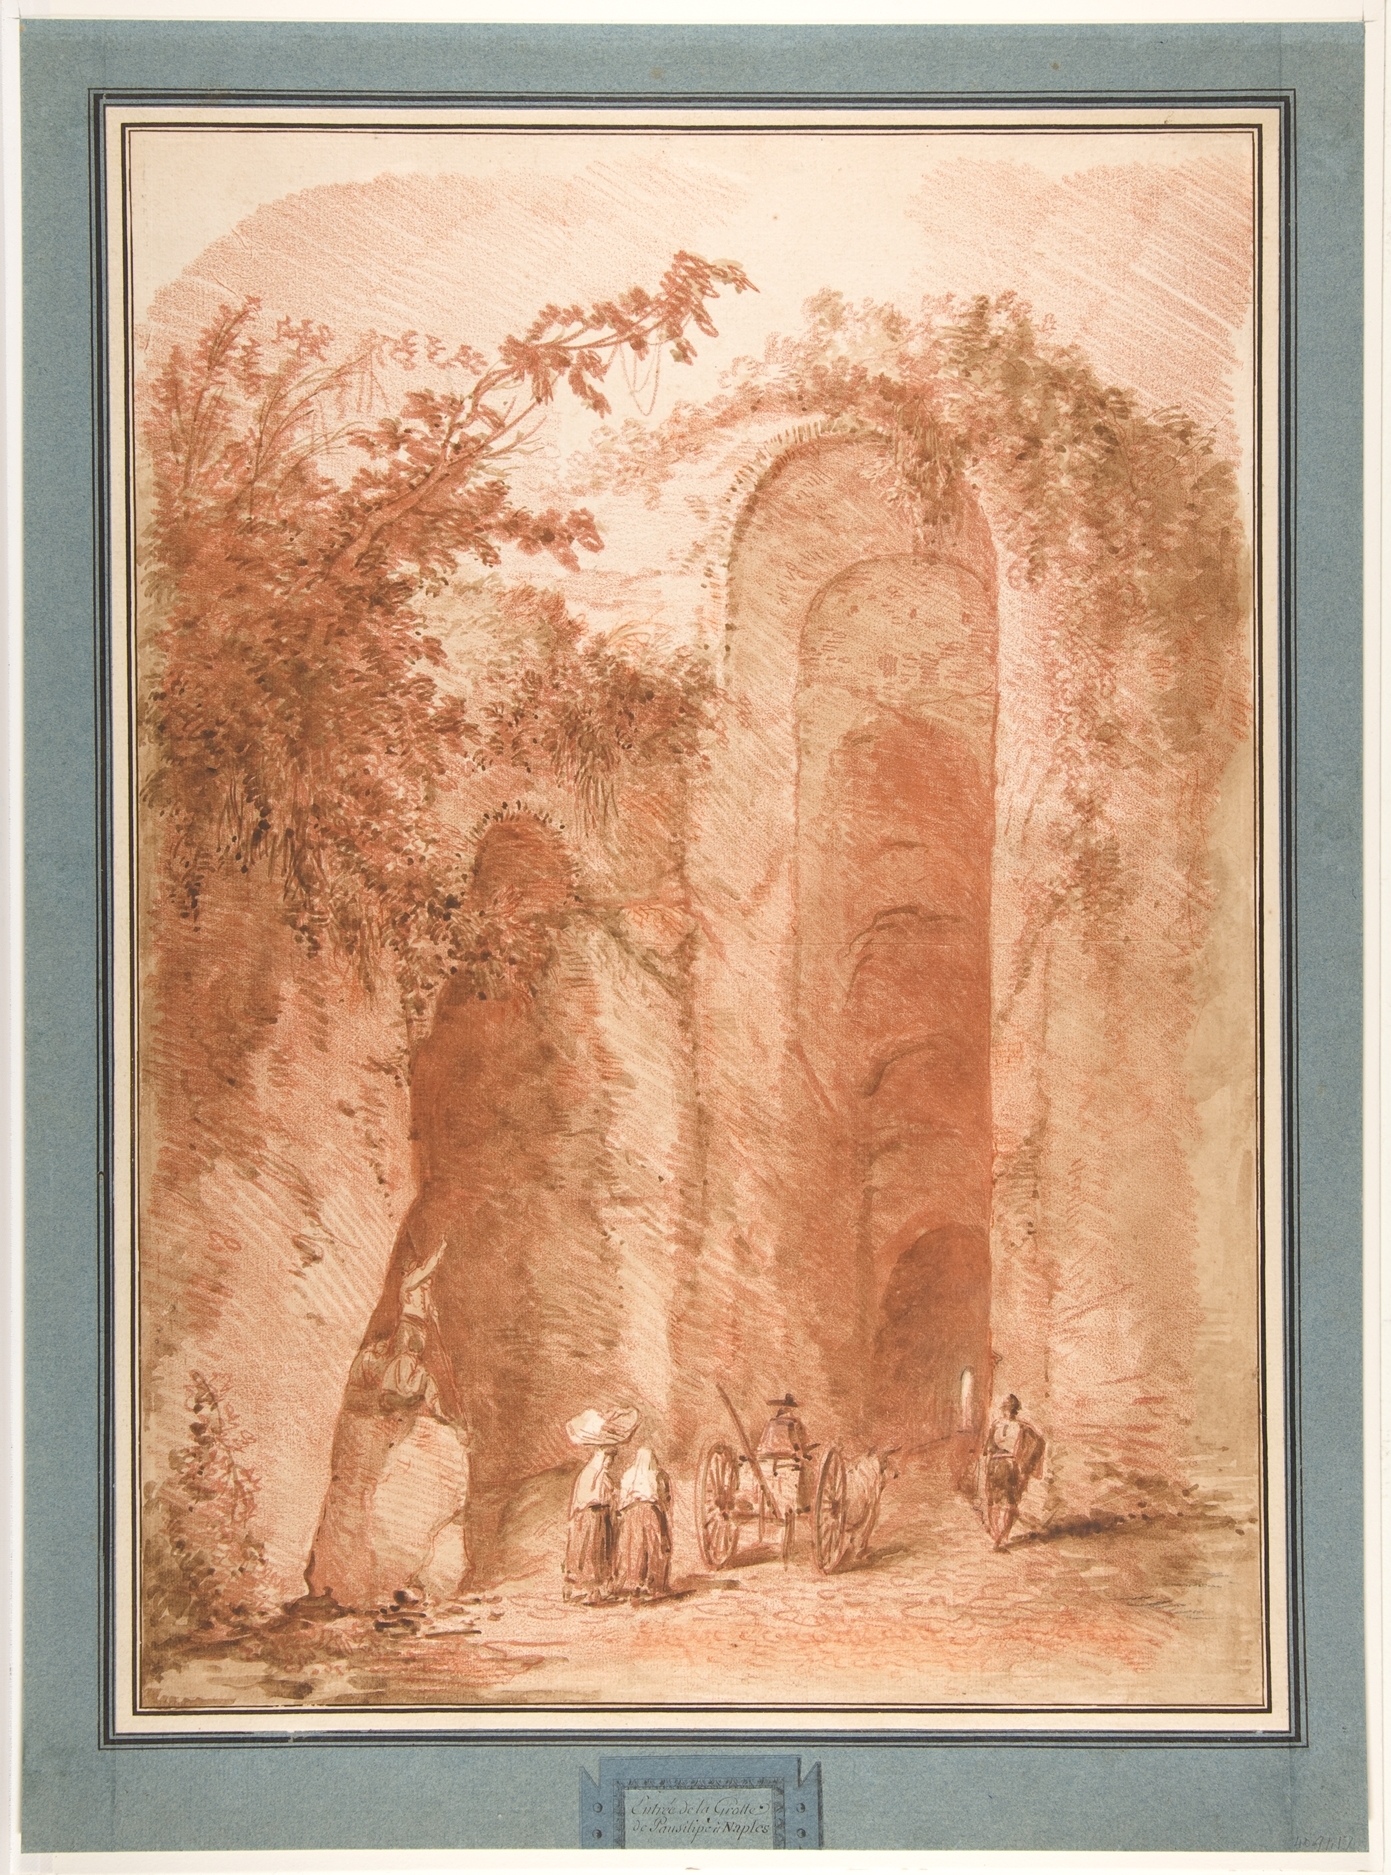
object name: drawing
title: Entrance to the Grotto of Posillipo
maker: hubert robert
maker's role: artist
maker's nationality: french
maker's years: 1733-1808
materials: chalk, ink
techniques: brush, printmaking, pen, wash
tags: caves